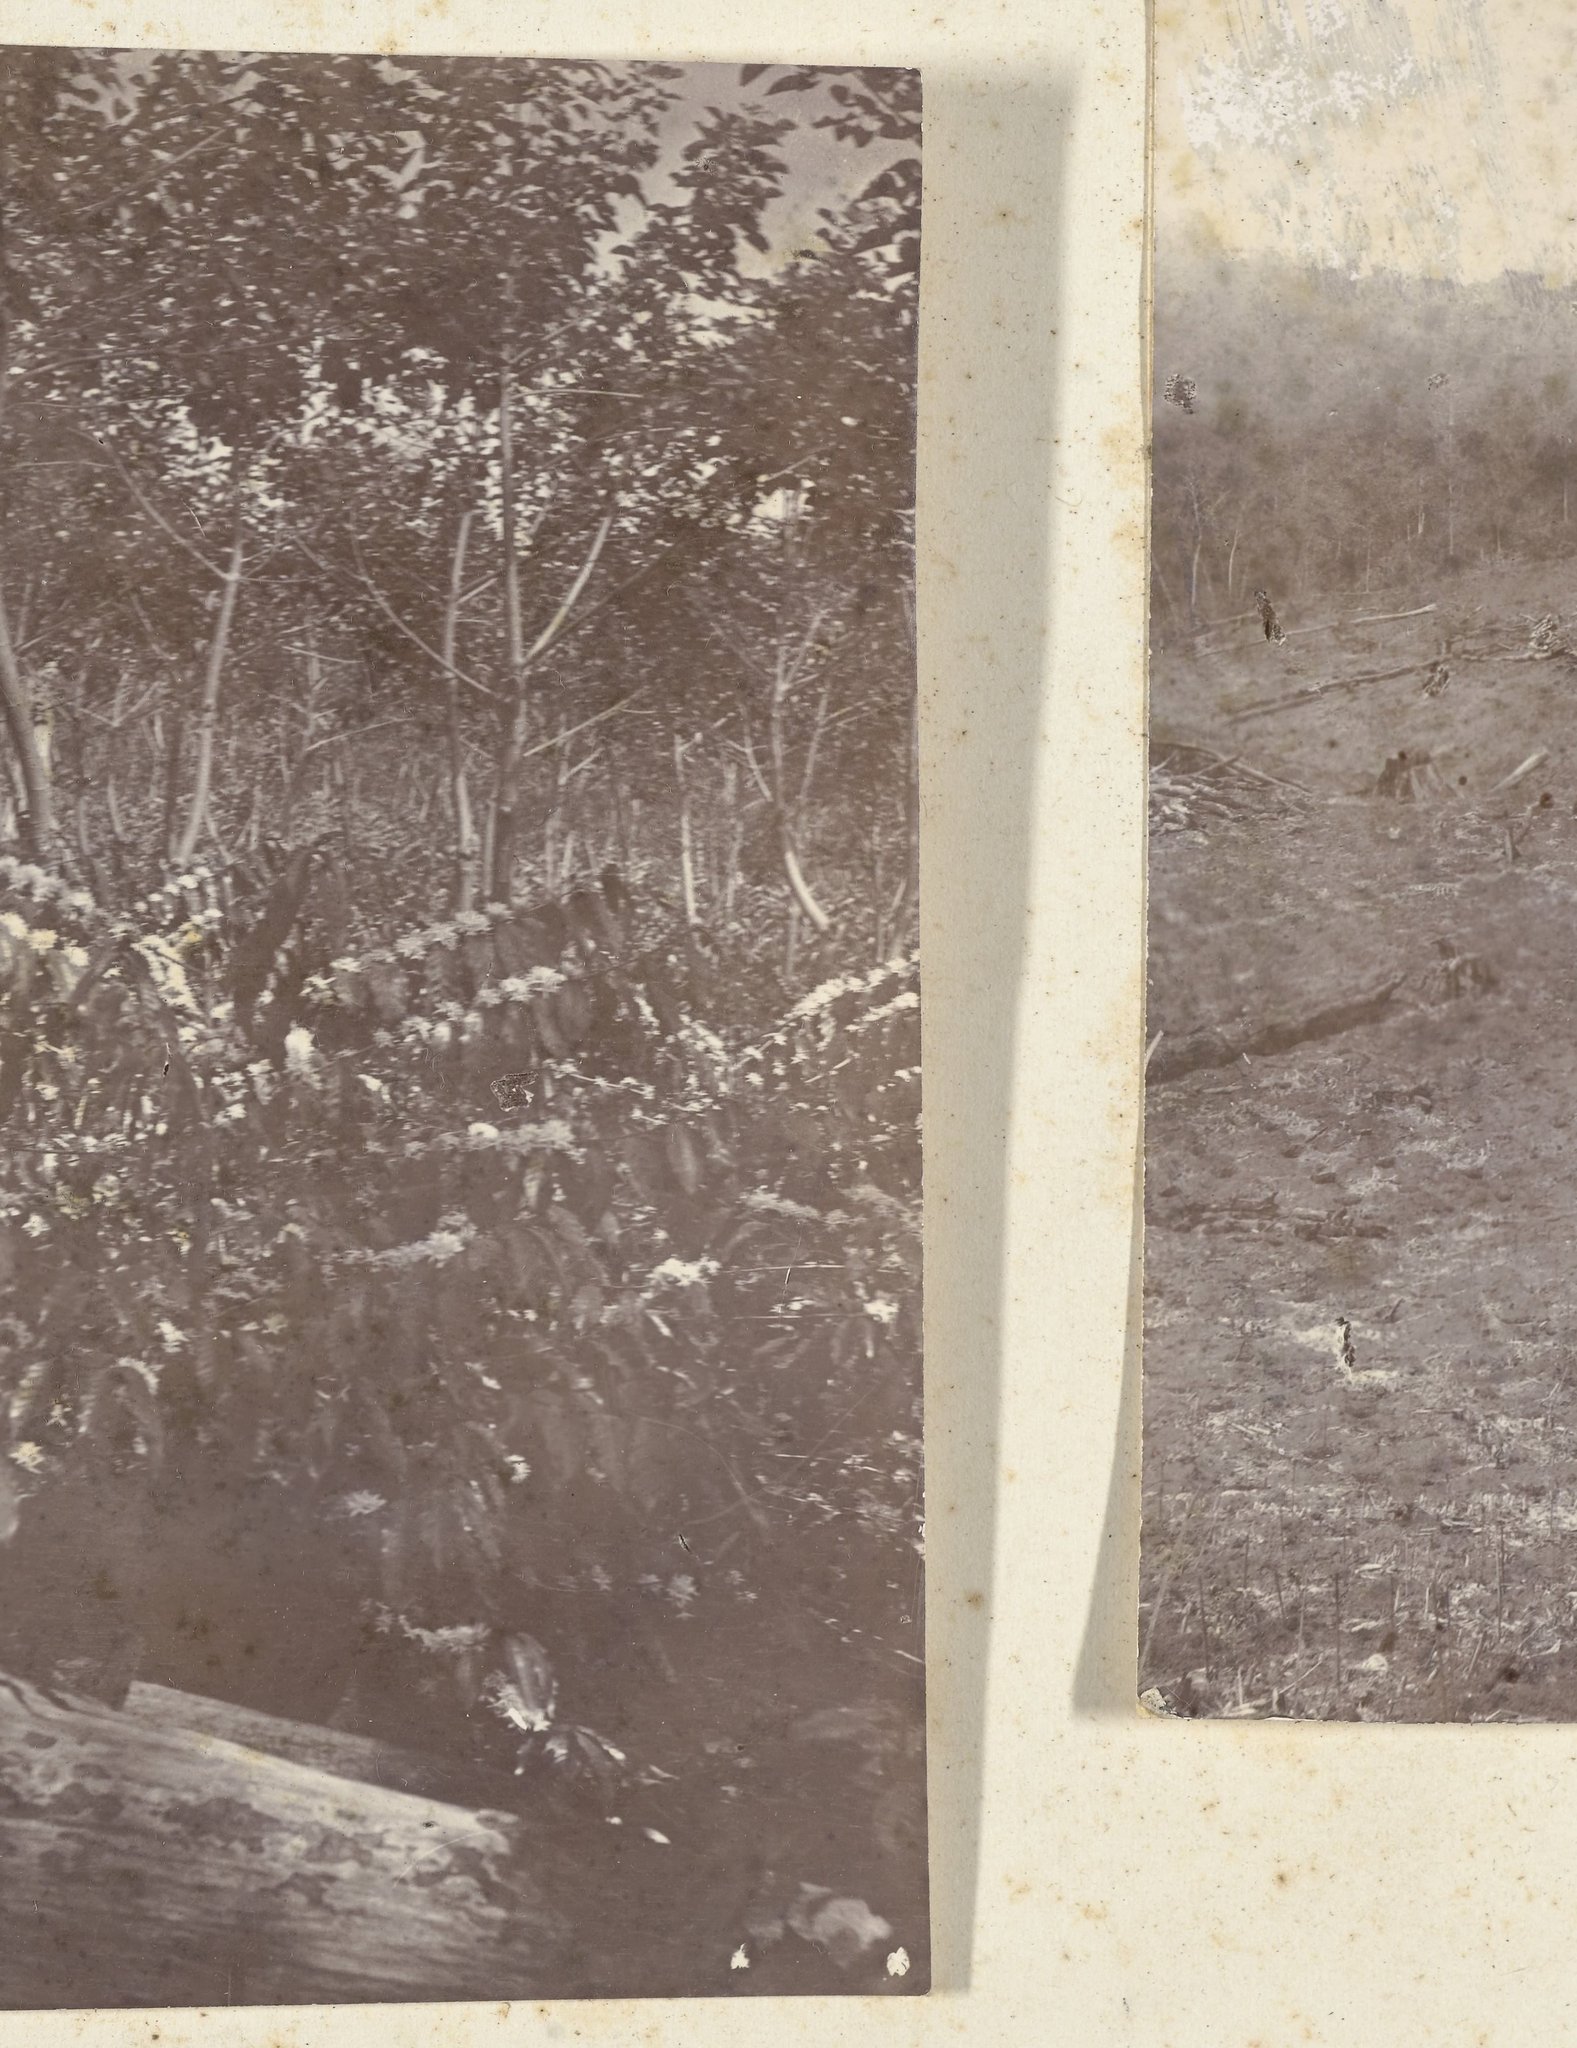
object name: photograph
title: Koffieplanten op plantage Silo Sanen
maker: Anonymous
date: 1890-1910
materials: cardboard, photographic support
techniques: gelatin silver print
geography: indonesia